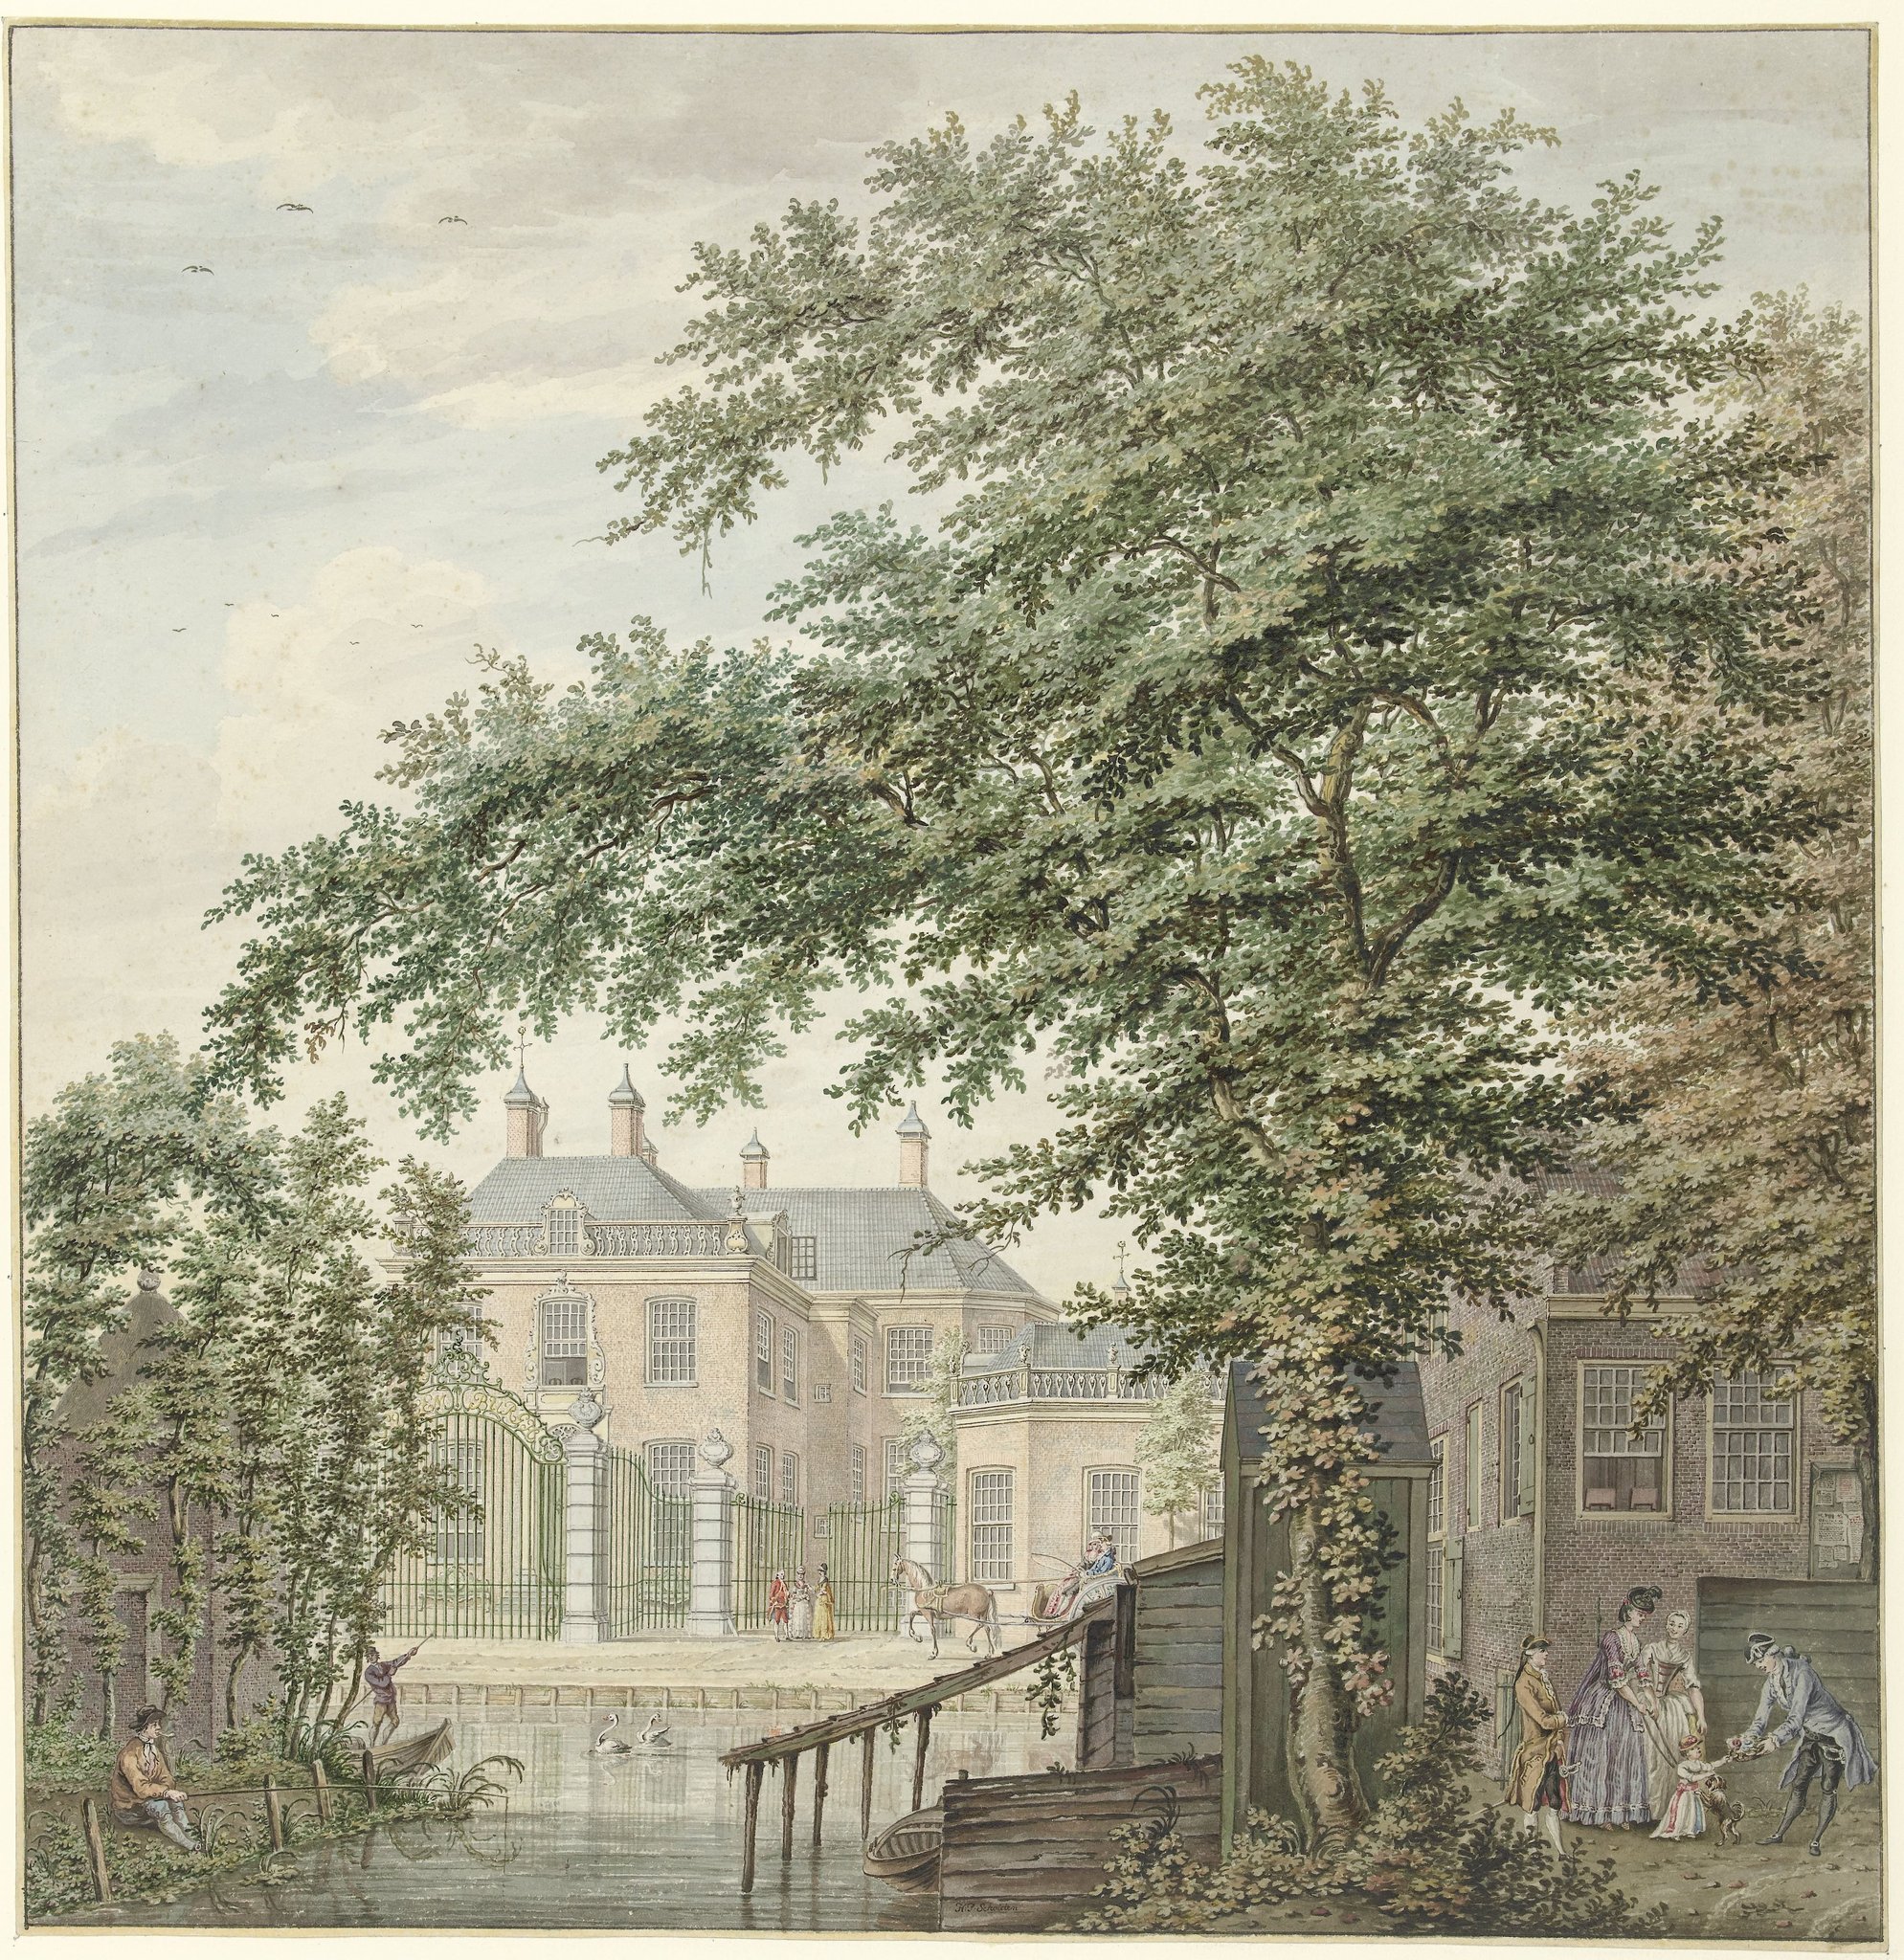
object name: watercolor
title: View of Luxemburg House at Maarssen on the Vecht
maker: hermanus petrus schouten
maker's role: draughtsman, painter, print maker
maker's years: 1747-1822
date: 1757-1822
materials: ink, paper, pencil, watercolor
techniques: brush, pen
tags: castle, maarssen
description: Many of Amsterdam’s wealthy merchants had country estates along the River Vecht, similar to Luxemburg House. In this drawing, artist Hermanus Petrus Schouten depicted the house more meticulously than he usually did in his topographical views. Behind the dark foreground and a corner of some other, smaller country estate lies Luxemburg, bathed in gentle sunlight, on the opposite bank of the Vecht.